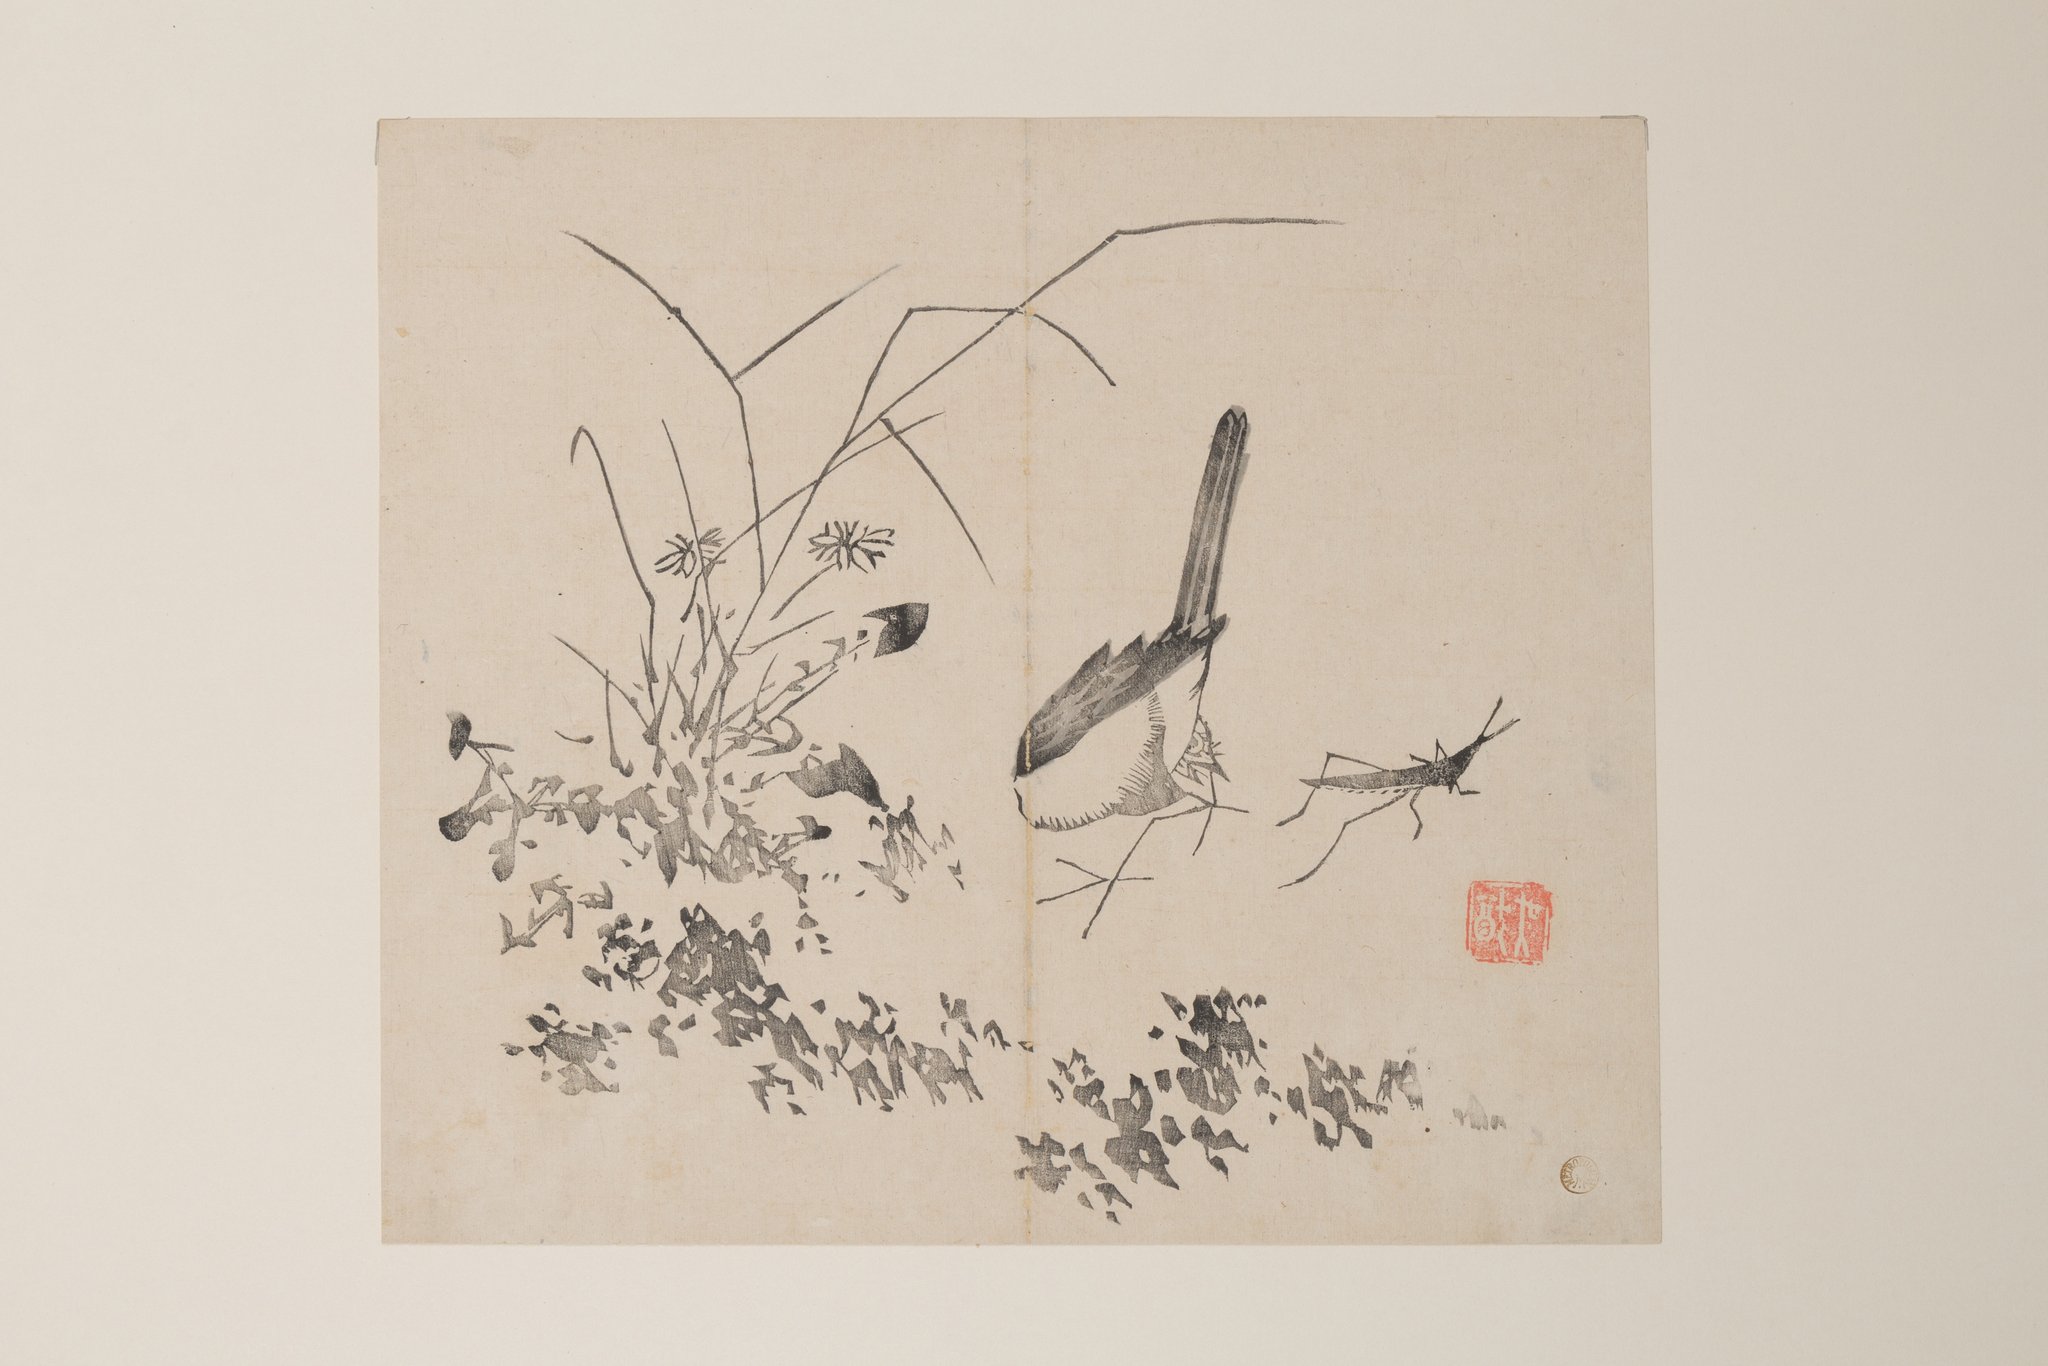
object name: print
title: Leaf from the Ten Bamboo Studio Manual of Painting and Calligraphy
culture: chinese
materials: ink, paper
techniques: printing